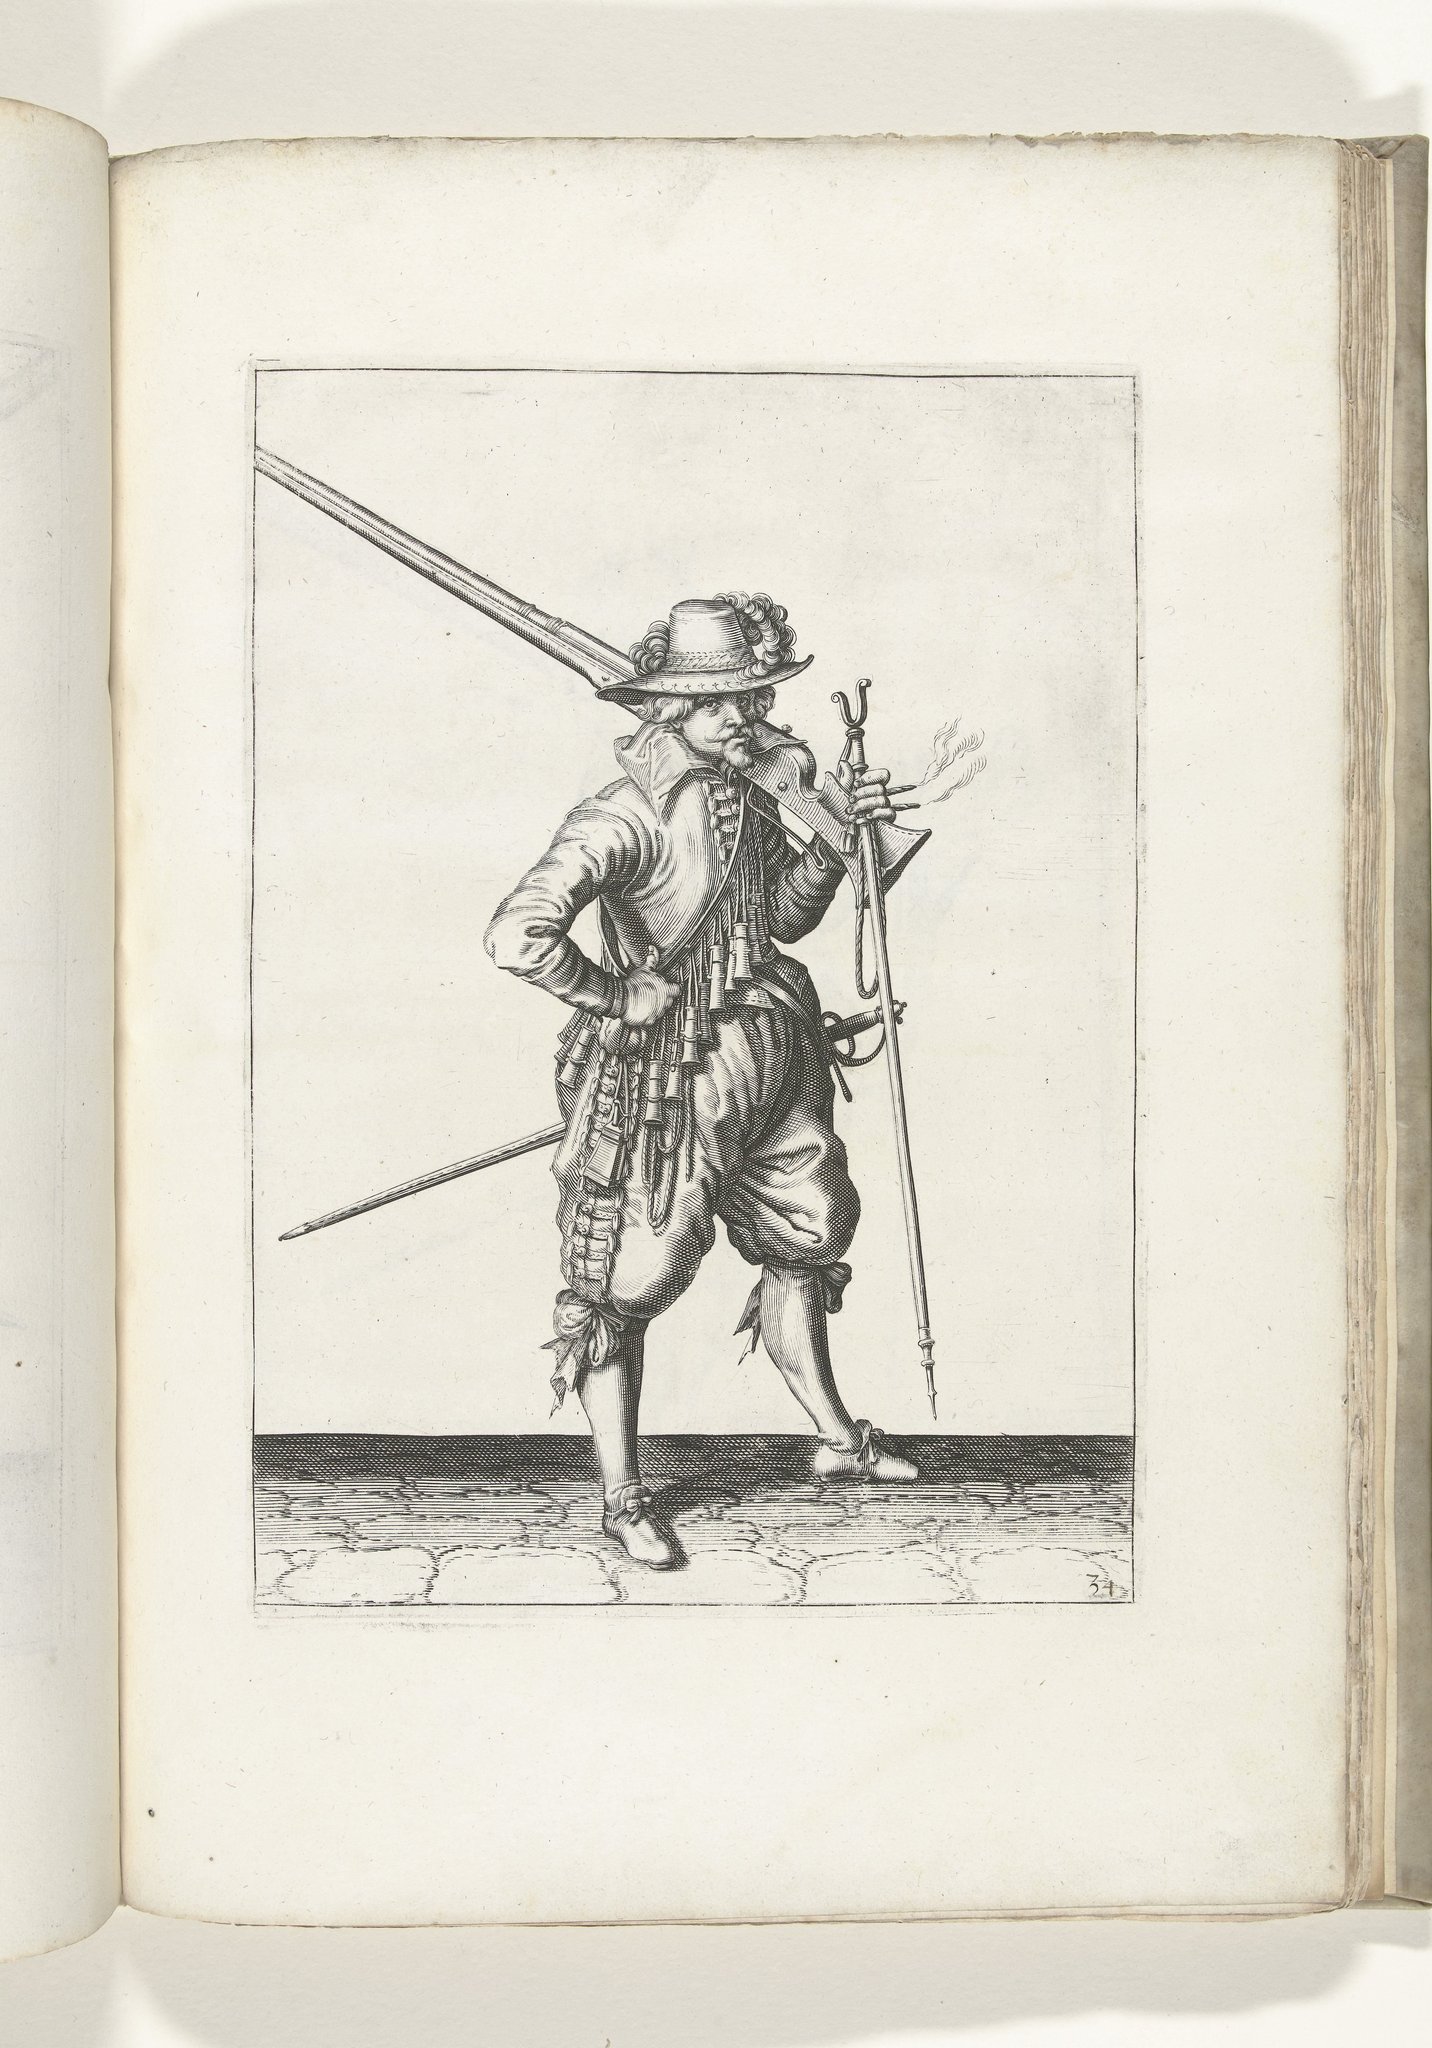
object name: print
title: Soldaat die zijn musket op zijn schouder draagt (nr. 34), ca. 1600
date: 1597-1607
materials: paper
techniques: engraving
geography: northern netherlands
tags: maurice (prince of orange), handling of weapons ~ military training, weapons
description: Een soldaat, ten voeten uit, naar rechts, met een musket (een bepaald type vuurwapen) steunend op zijn linkerschouder (nr. 34), ca. 1600. In zijn linkerhand behalve de kolf van het musket ook een brandende lont en een furket (musketvork). Het gaat dus om (vrijwel) dezelfde positie als degene die op de tweede prent van de serie getoond wordt. Rechtsonder foutief genummerd 2, met de pen verbeterd in 34. Plaat 34 in de instructies voor het hanteren van het musket: Corte onderrechtinghe op de figuerliicke afbeeldinghe, soo veel aengaet het recht ghebruyck vant Musquet. Onderdeel van de illustraties in: J. de Gheyn, Wapenhandelinghe van Roers Musquetten ende spiessen, 's-Gravenhage, 1607. Krijgswezen rond 1600.